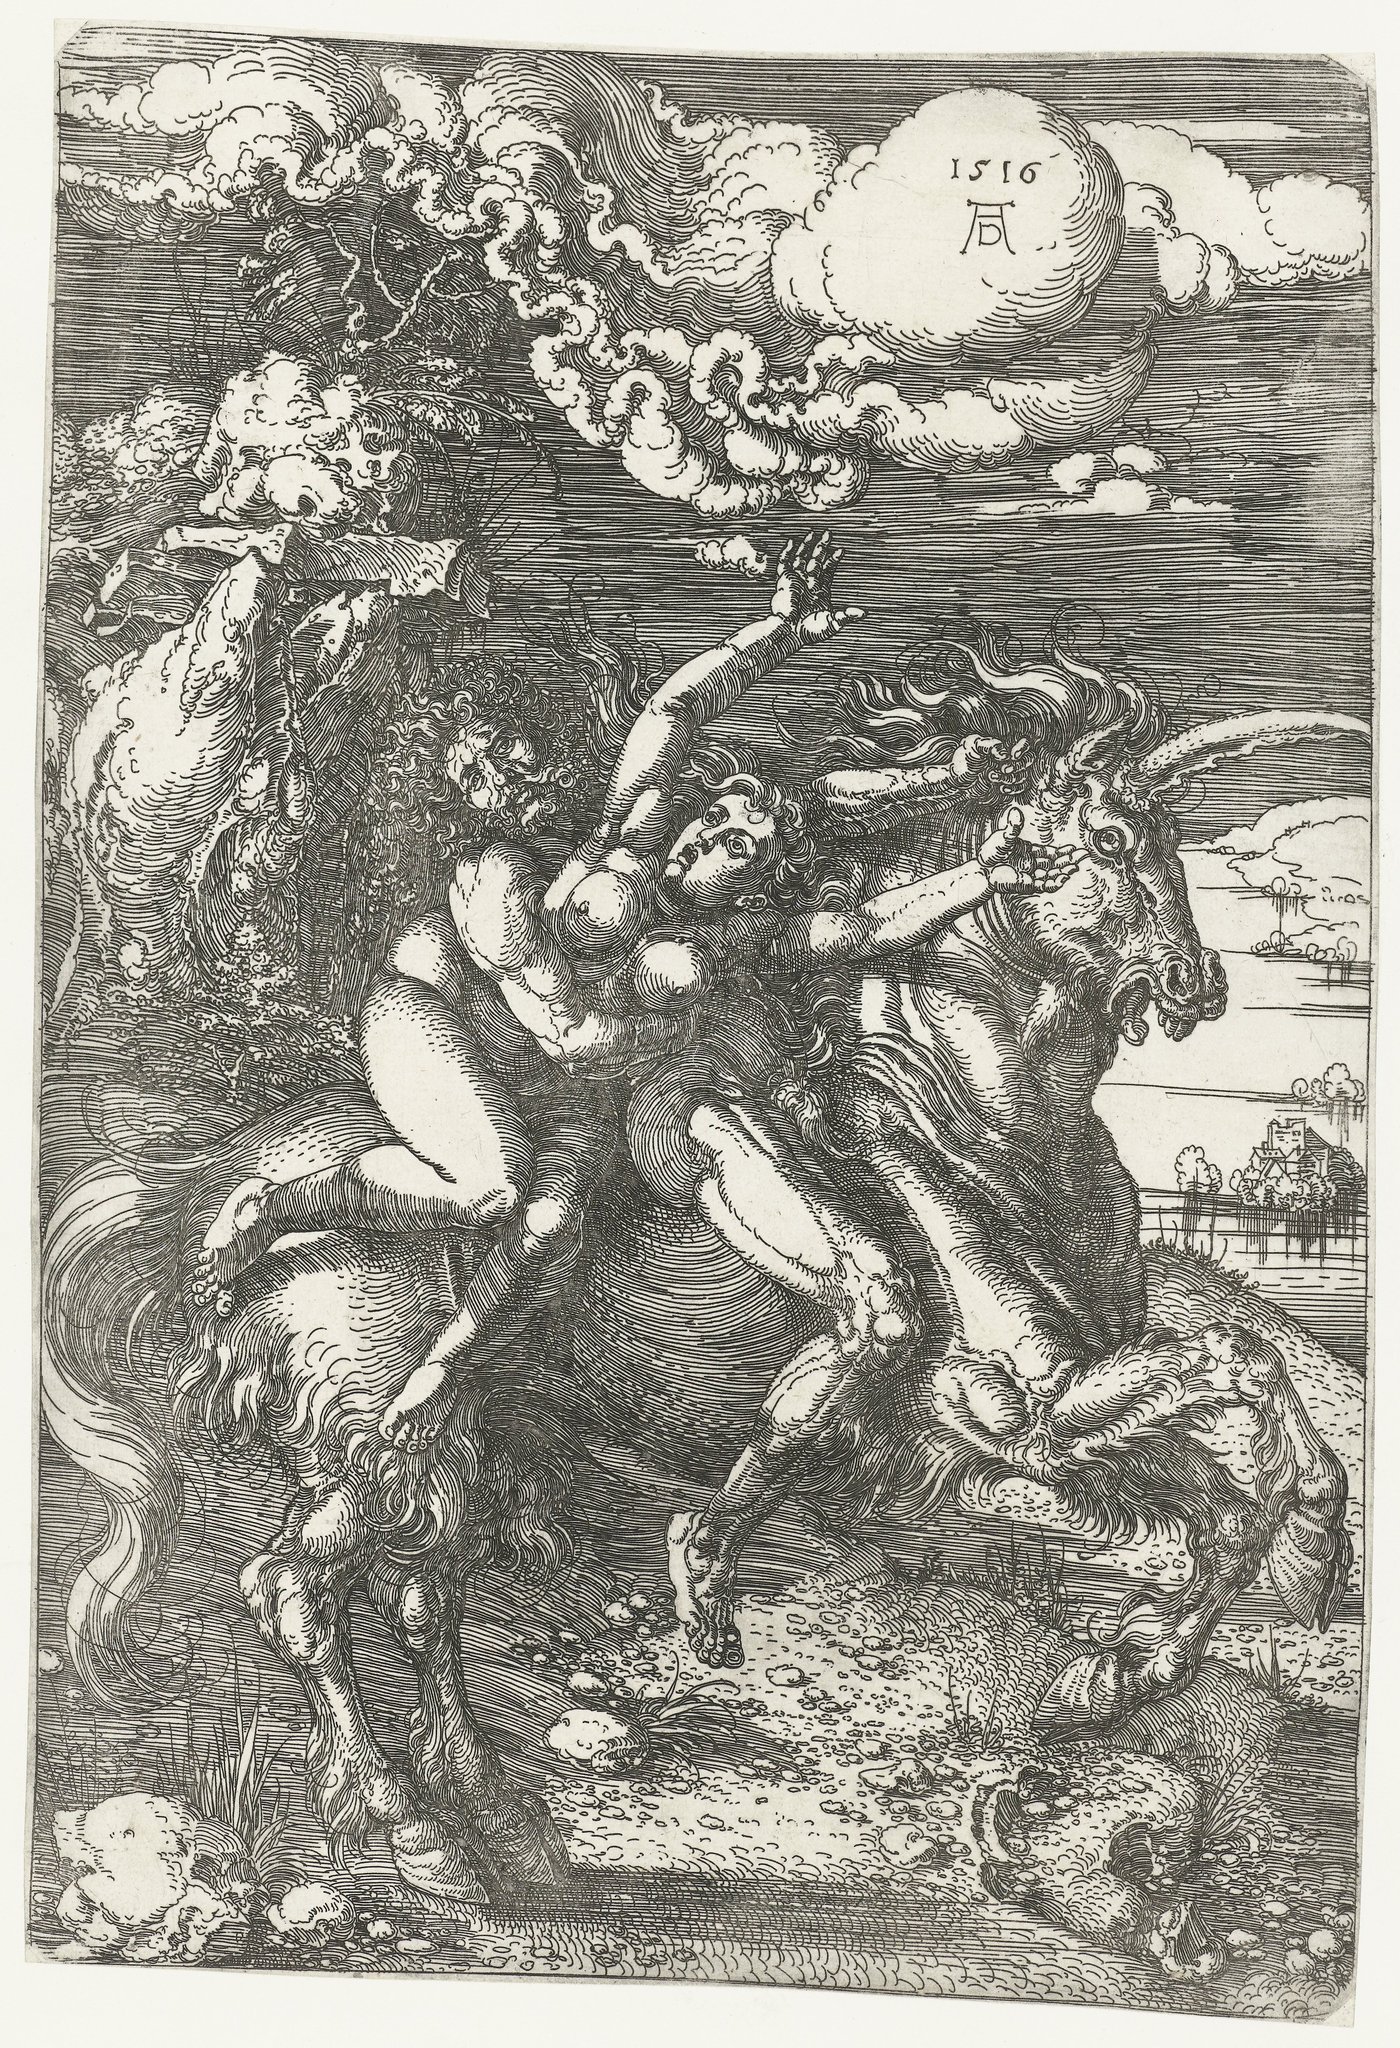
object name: print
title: Roof van Proserpina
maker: albrecht dürer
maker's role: draughtsman, painter, print maker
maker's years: 1471-1528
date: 1516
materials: paper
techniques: etching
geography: nuremberg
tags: (story of) proserpina (persephone, core), libera, unicorn, the rape of proserpina (by pluto in his chariot); possibly with diana and minerva trying to rescue her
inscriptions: collector's mark: Lugt 2228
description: In een bergachtige omgeving wordt een naakte vrouw door een man op een eenhoorn meegevoerd. Op de achtergrond een huis aan een water.